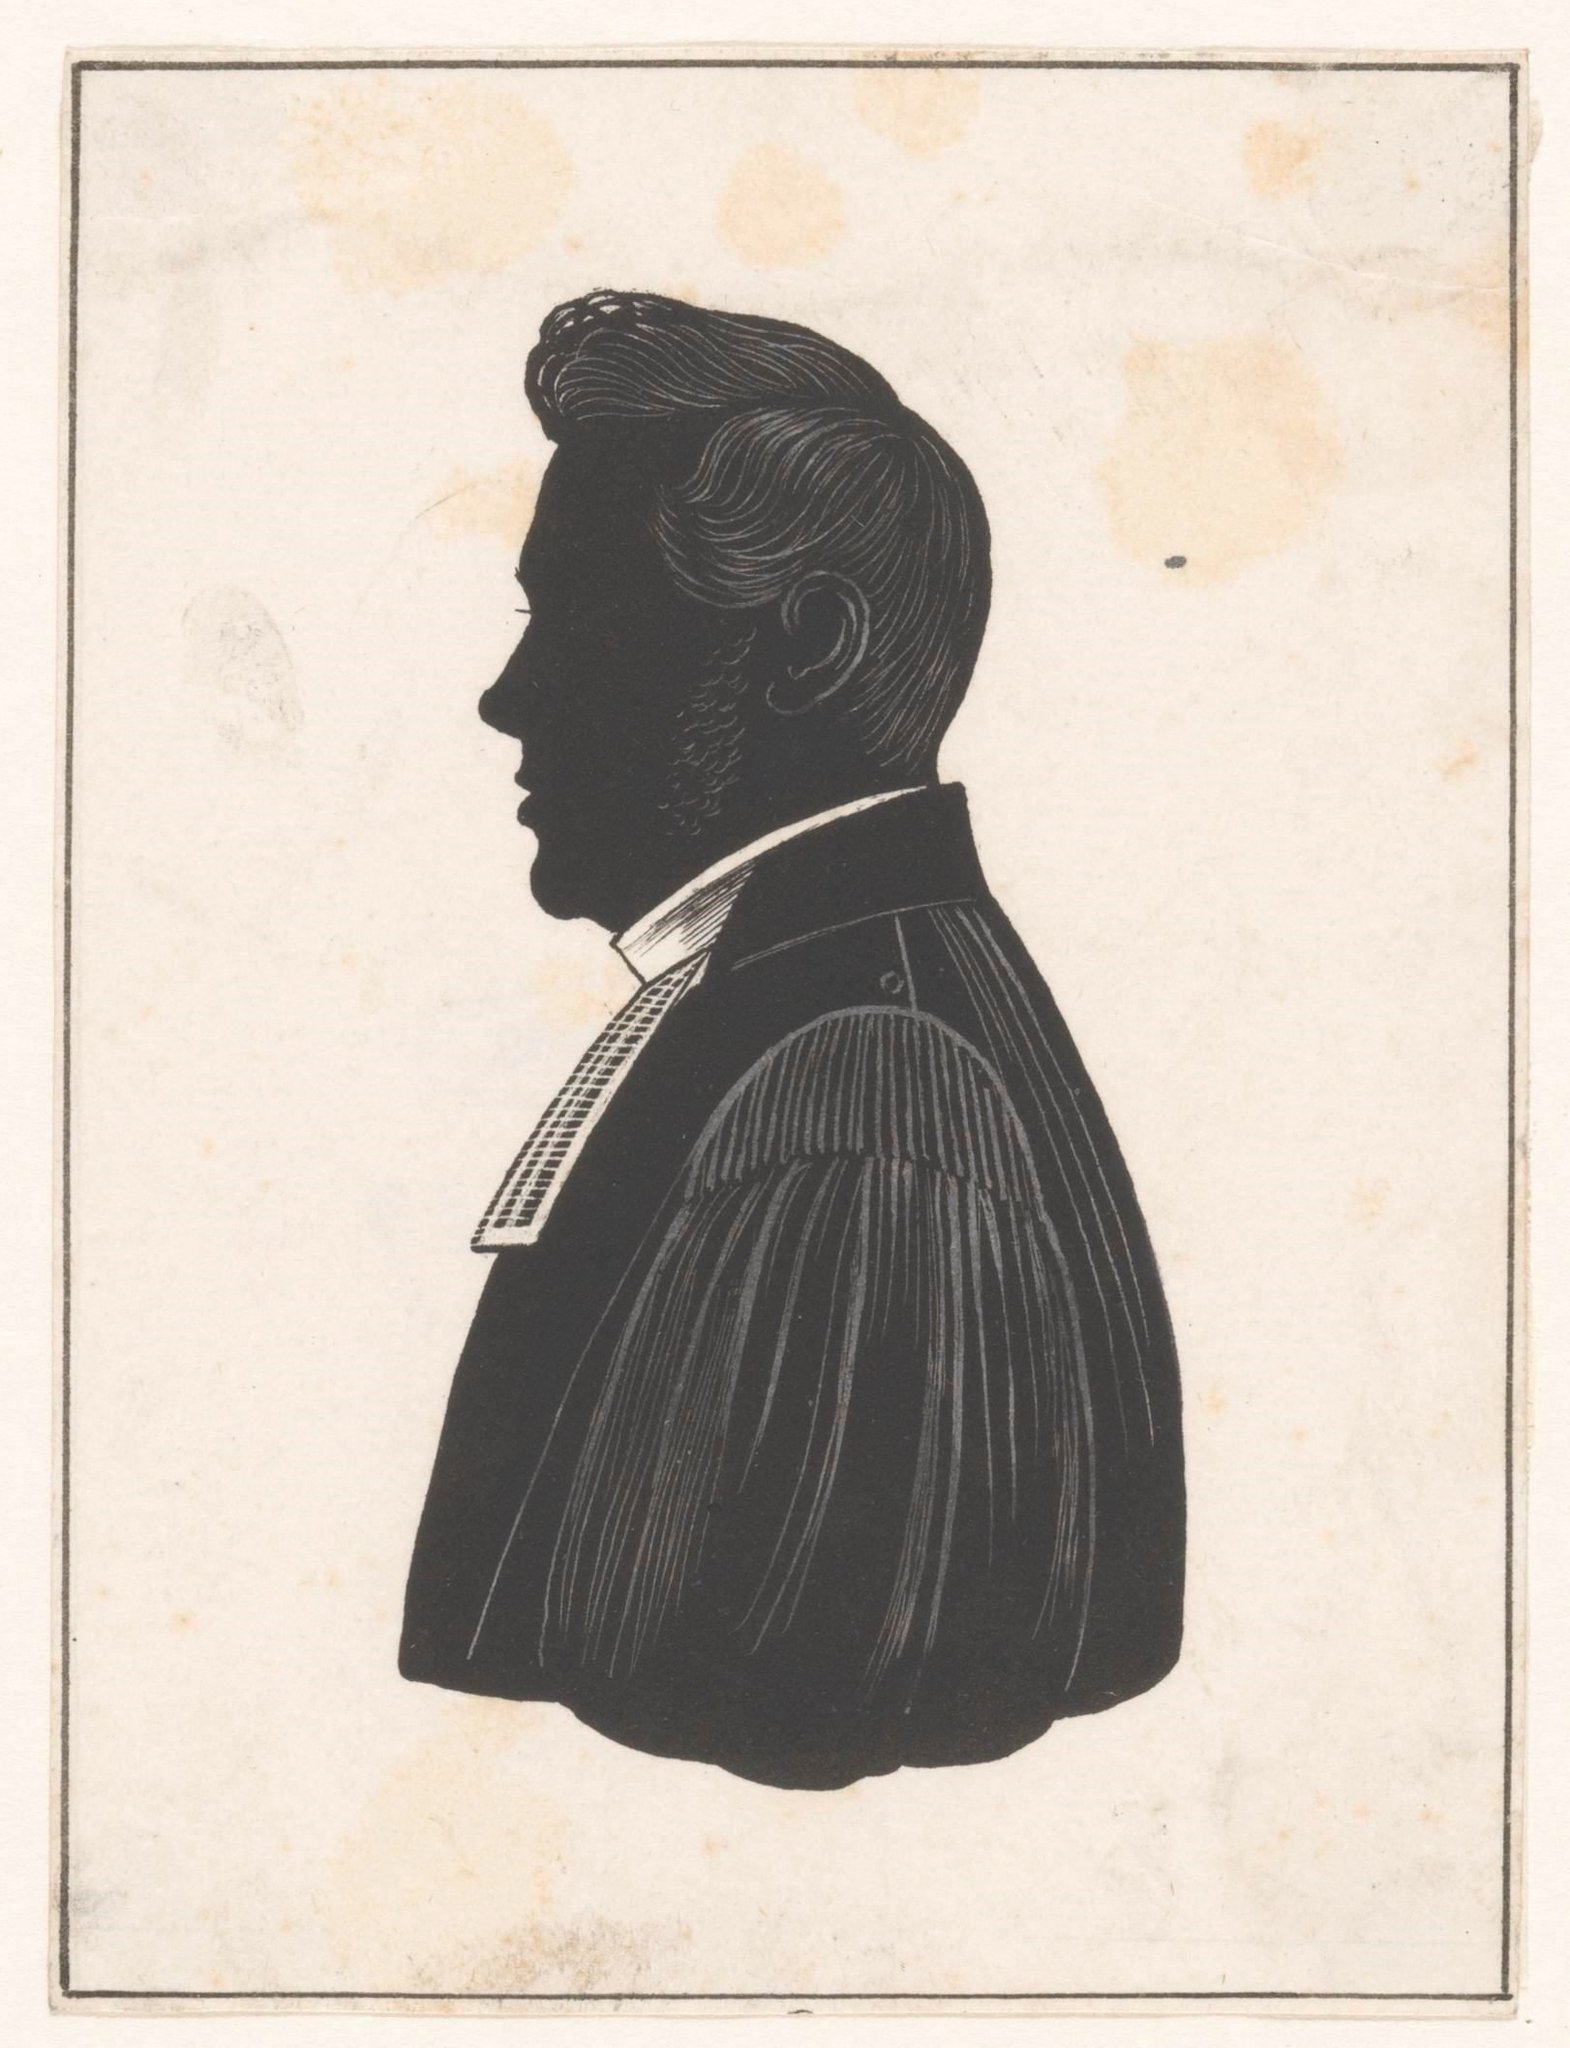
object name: print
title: Silhouetportret van de heer Deeleman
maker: friedrich heinrich wilhelm schröder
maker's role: draughtsman, print maker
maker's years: 1818-1870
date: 1833-1870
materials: paper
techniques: hand coloring, lithograph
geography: netherlands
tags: historical persons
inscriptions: collector's mark: Lugt 2228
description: Onder het portret de signatuur van de geportretteerde.